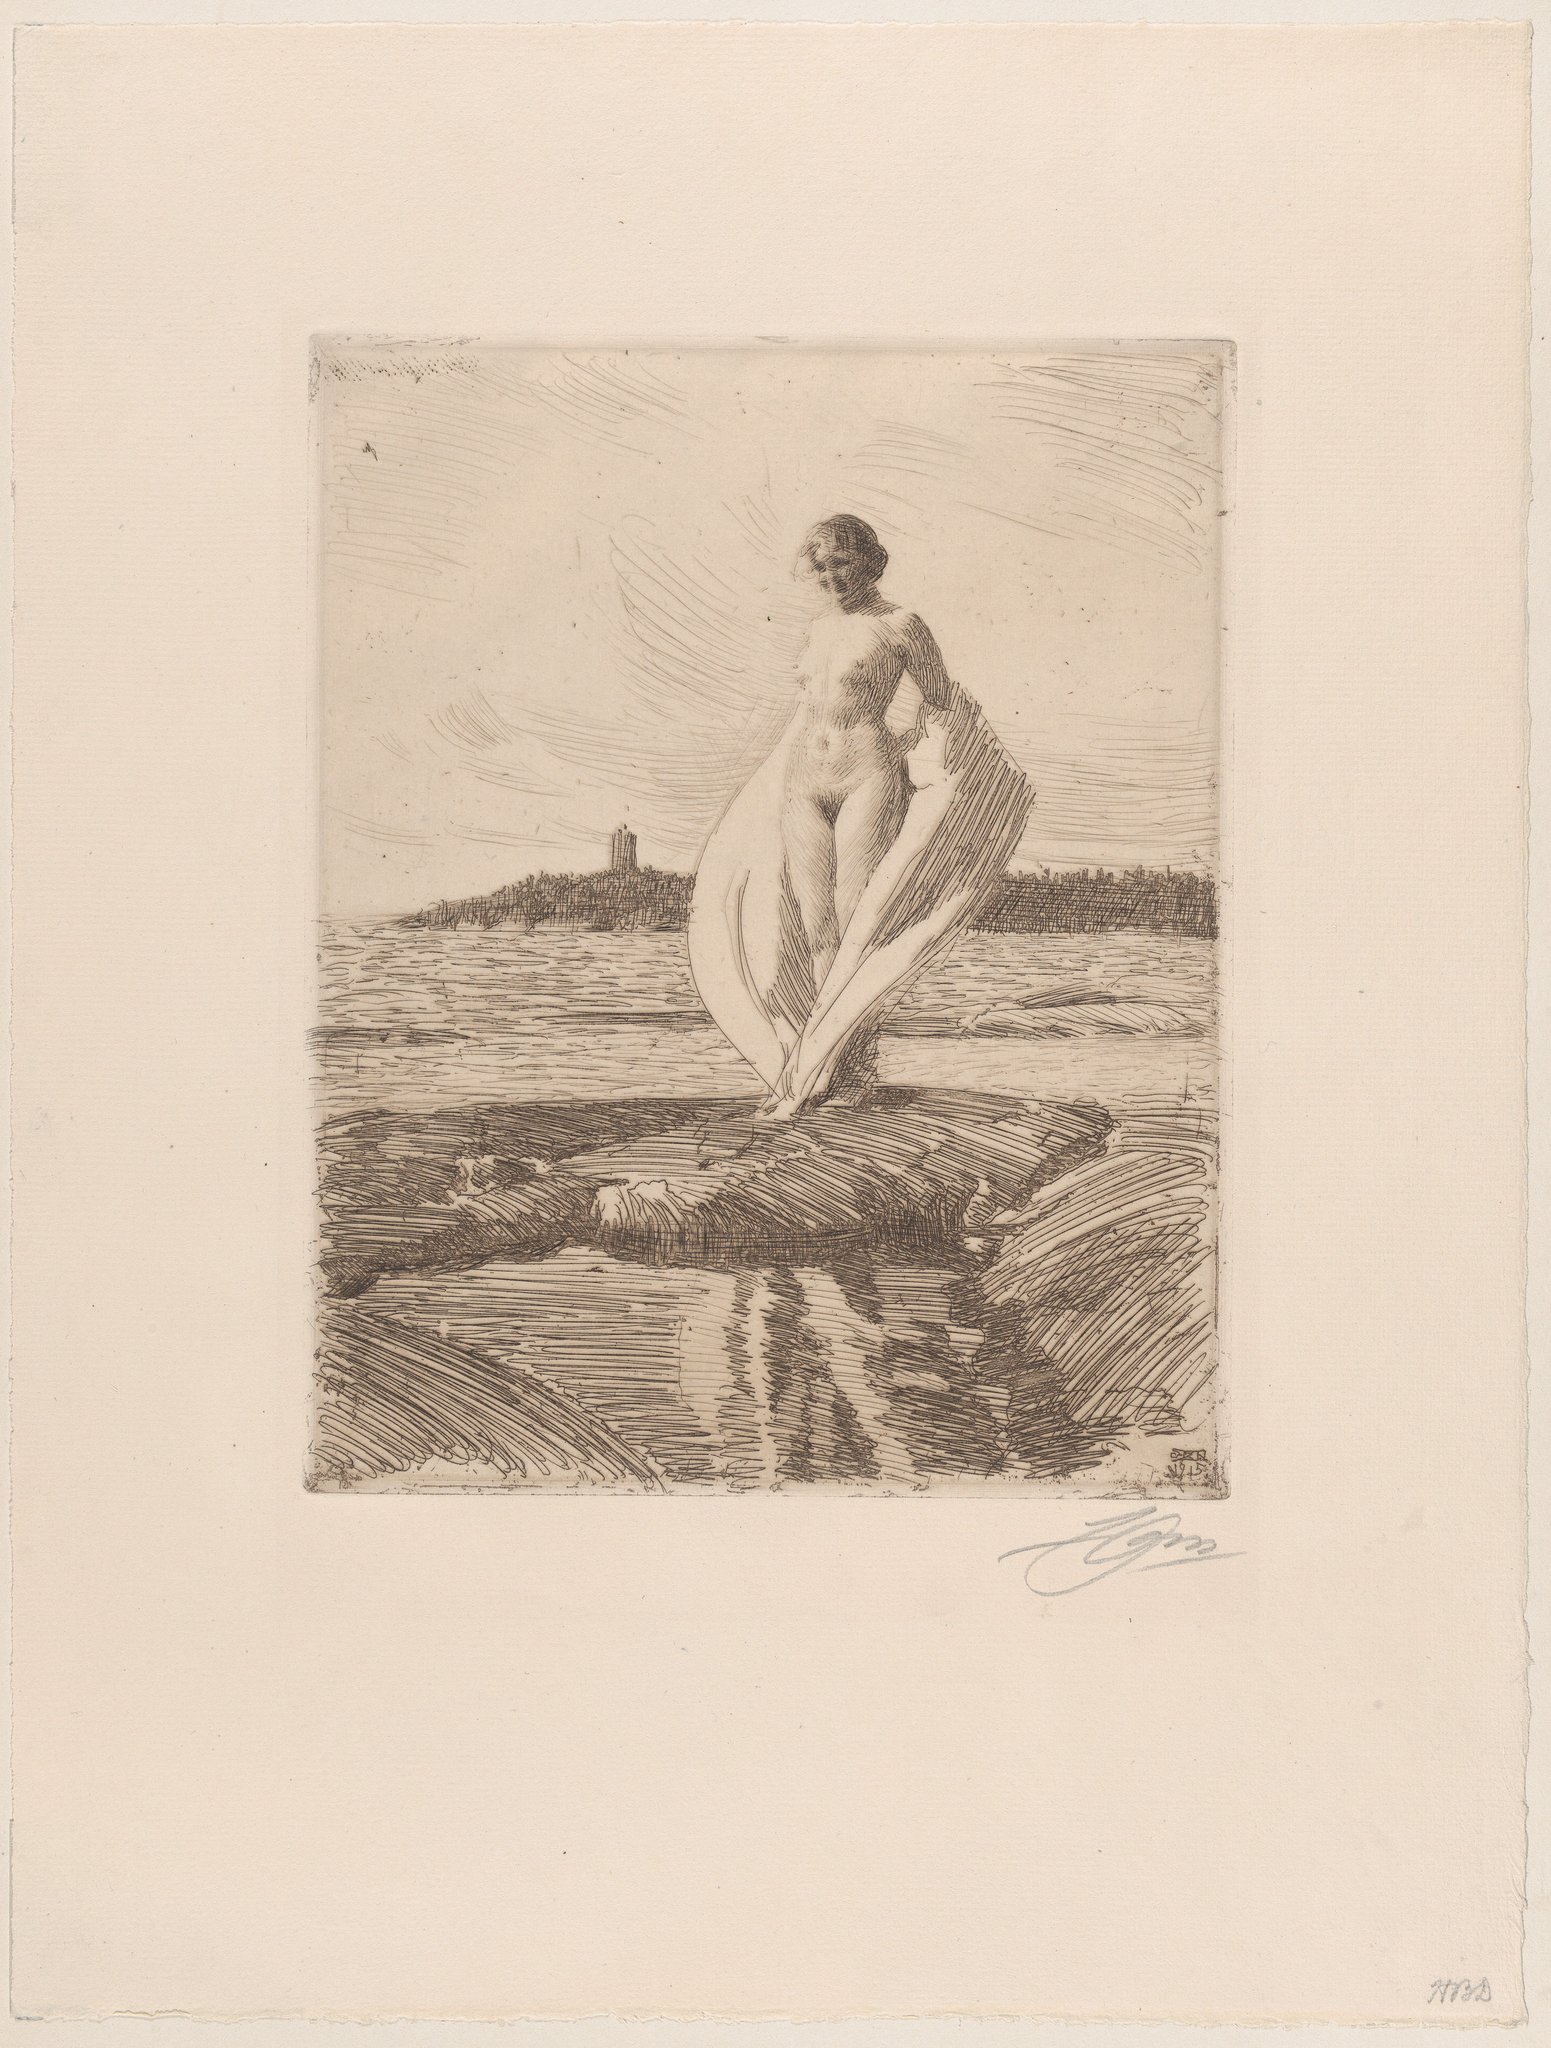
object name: print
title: The Swan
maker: anders zorn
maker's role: artist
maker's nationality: swedish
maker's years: 1860-1920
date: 1915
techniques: etching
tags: female nudes